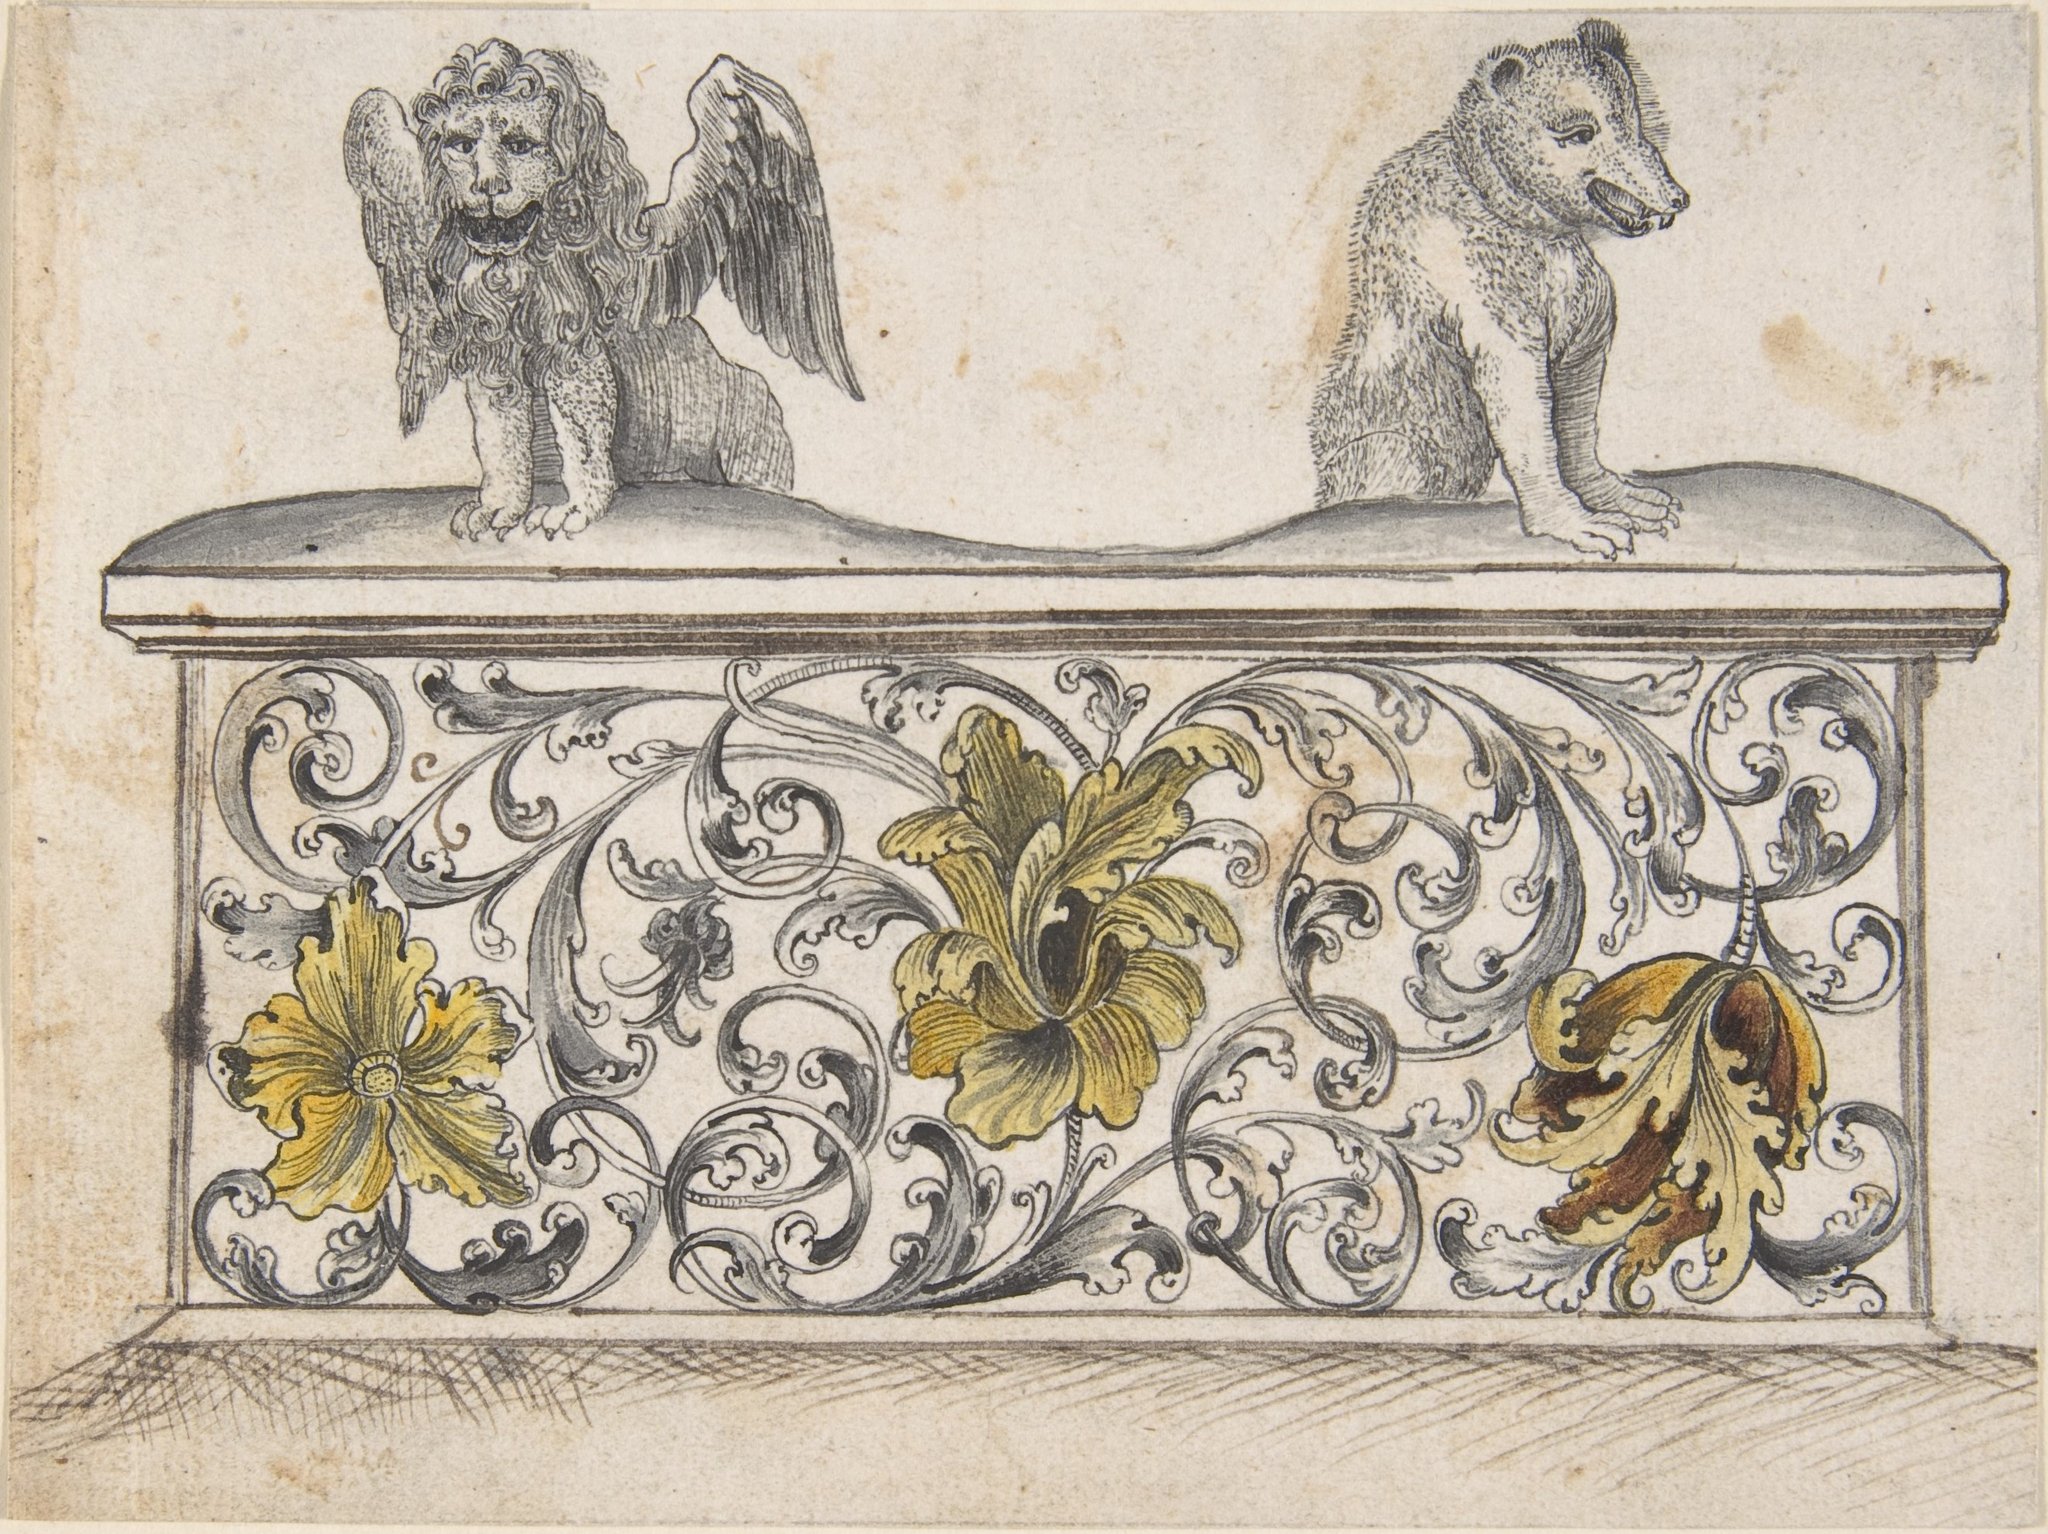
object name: drawing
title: Ornamental design for front of a chest with winged lion and bear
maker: anonymous, french, 19th century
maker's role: artist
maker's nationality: french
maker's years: 1800-1900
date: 1801-1900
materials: ink, watercolor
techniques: pen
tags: bears,ornament,flowers